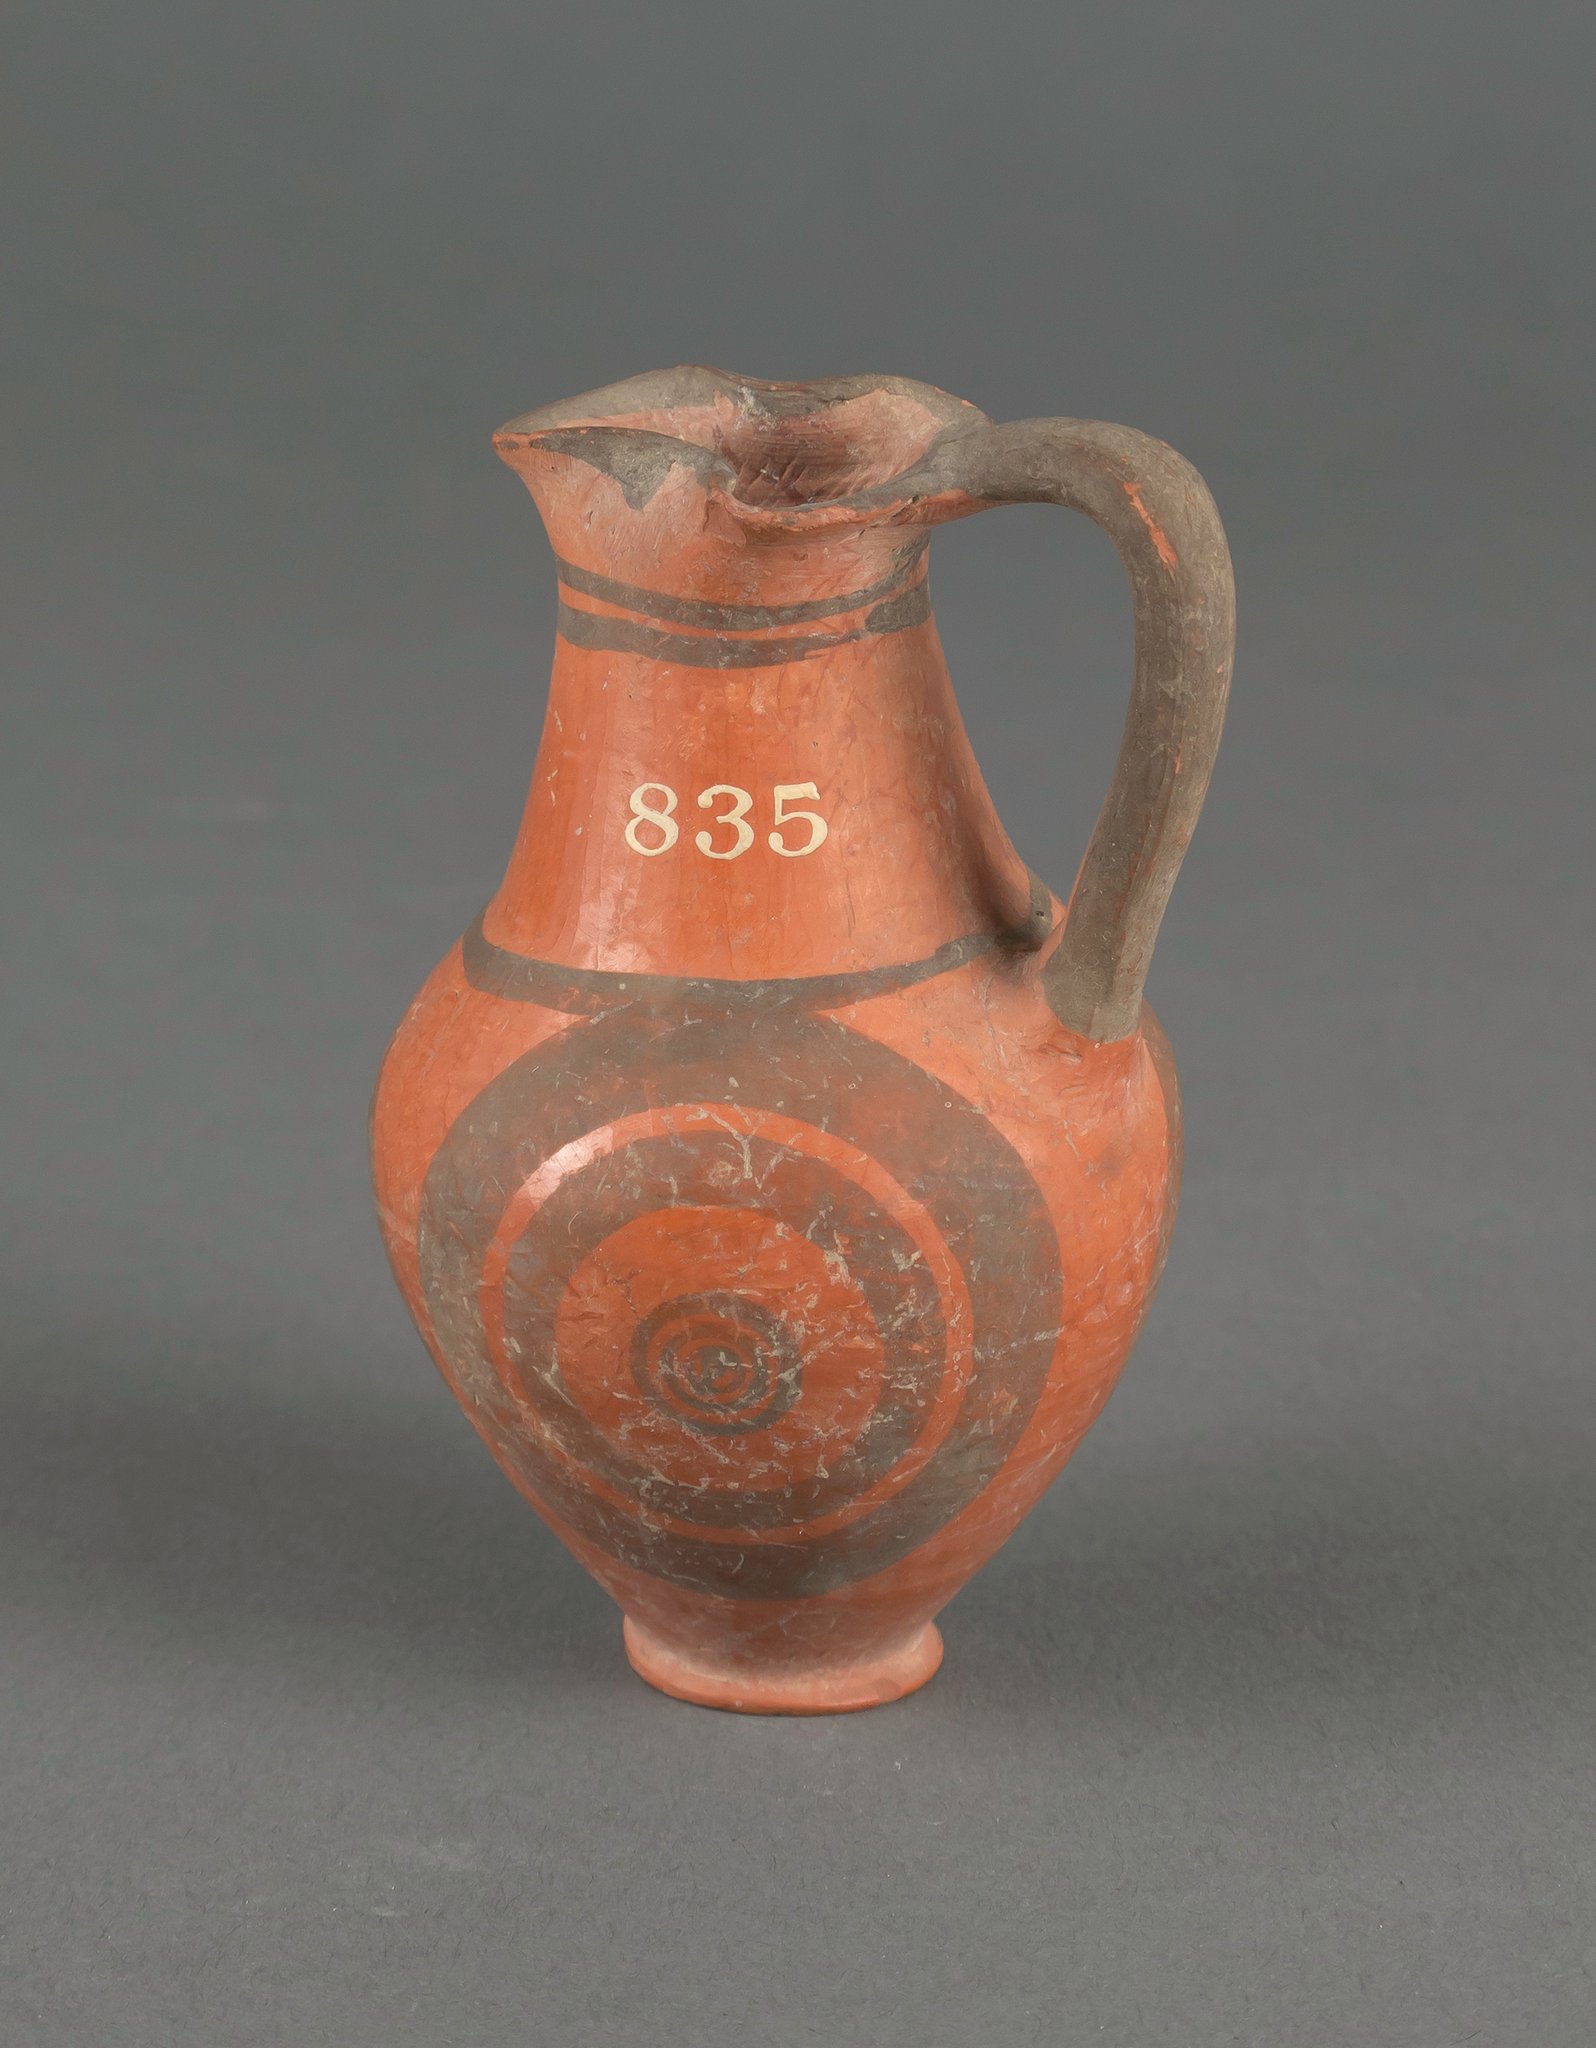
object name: juglet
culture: cypriot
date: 850-750 BCE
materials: terracotta